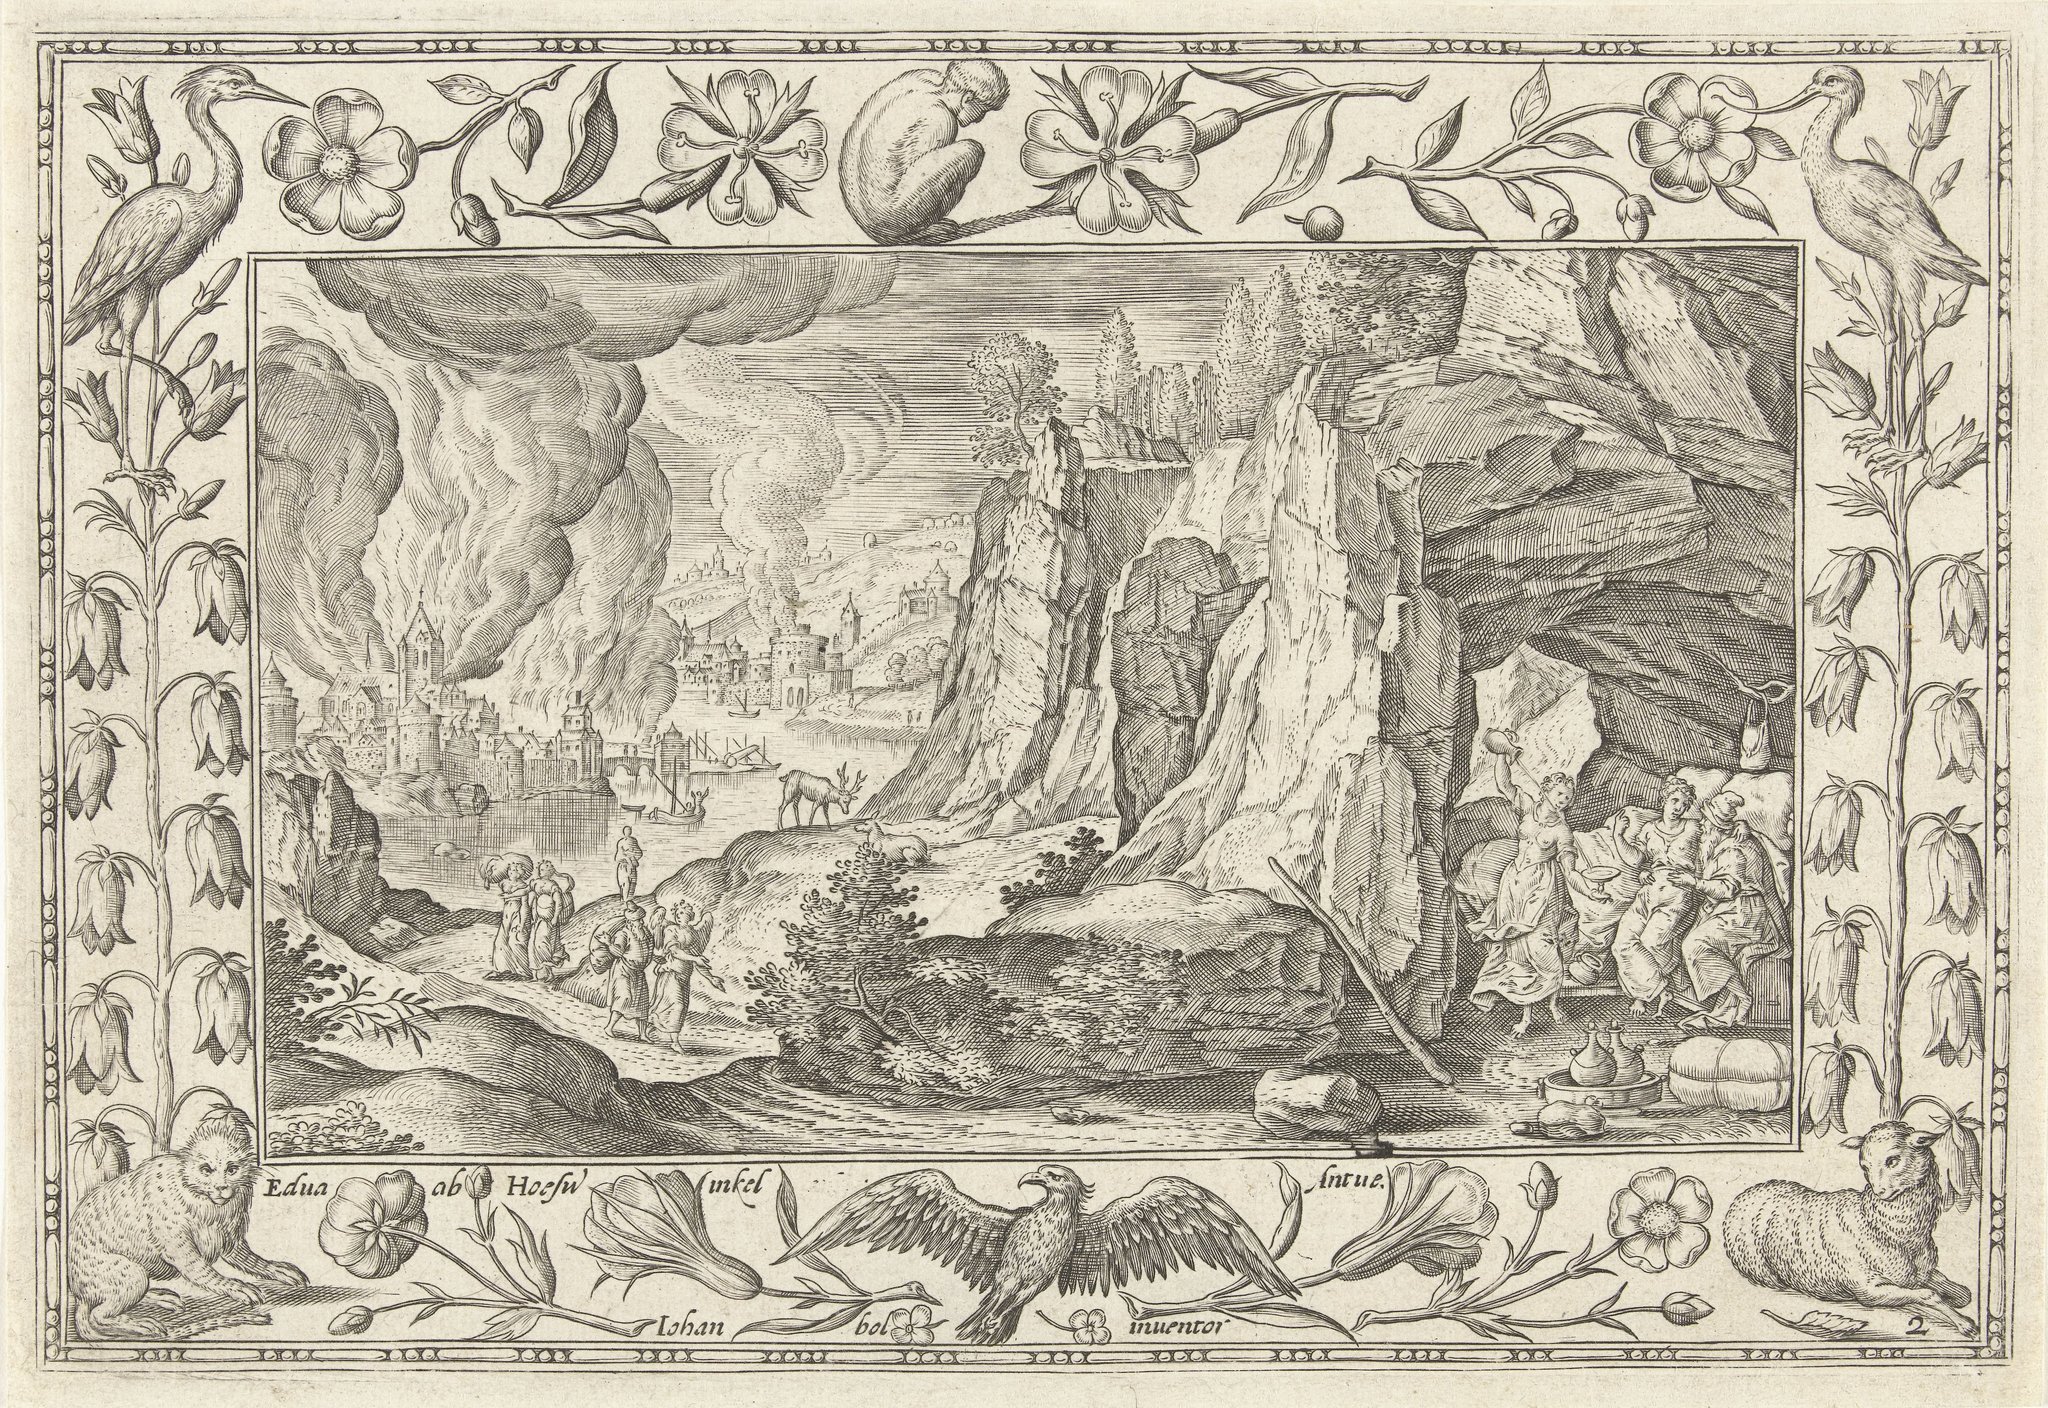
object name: print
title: Lot en zijn dochters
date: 1582-1586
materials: paper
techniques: engraving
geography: antwerp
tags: lamb, sodom and gomorrah burning, rocks, flowers (+ ornamental variants of plants), monkeys, apes (+ ornamental variants of animals), predatory birds: eagle (+ ornamental variants of animals), shore-birds and wading-birds: spoonbill (ornamental variants of animals), shore-birds and wading-birds (with name) (+ ornamental variants of animals), lot's wife looks back at the city and is transformed into a pillar of salt, lot's daughters make their father drunk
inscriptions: collector's mark: Lugt 2228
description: Rotslandschap met op de achtergrond de brandende steden Sodom en Gomorra. Op de voorgrond de vlucht van Lot en zijn familie. Zijn vrouw is veranderd in een zoutpilaar. Rechts op de voorgrond Lot met zijn dochters, die hem dronken voeren. De prent heeft een ornamentlijst met bloemen en dieren. Hij maakt deel uit van een vierentwintigdelige serie van landschappen met Bijbelse, mythologische scènes en jachttaferelen.